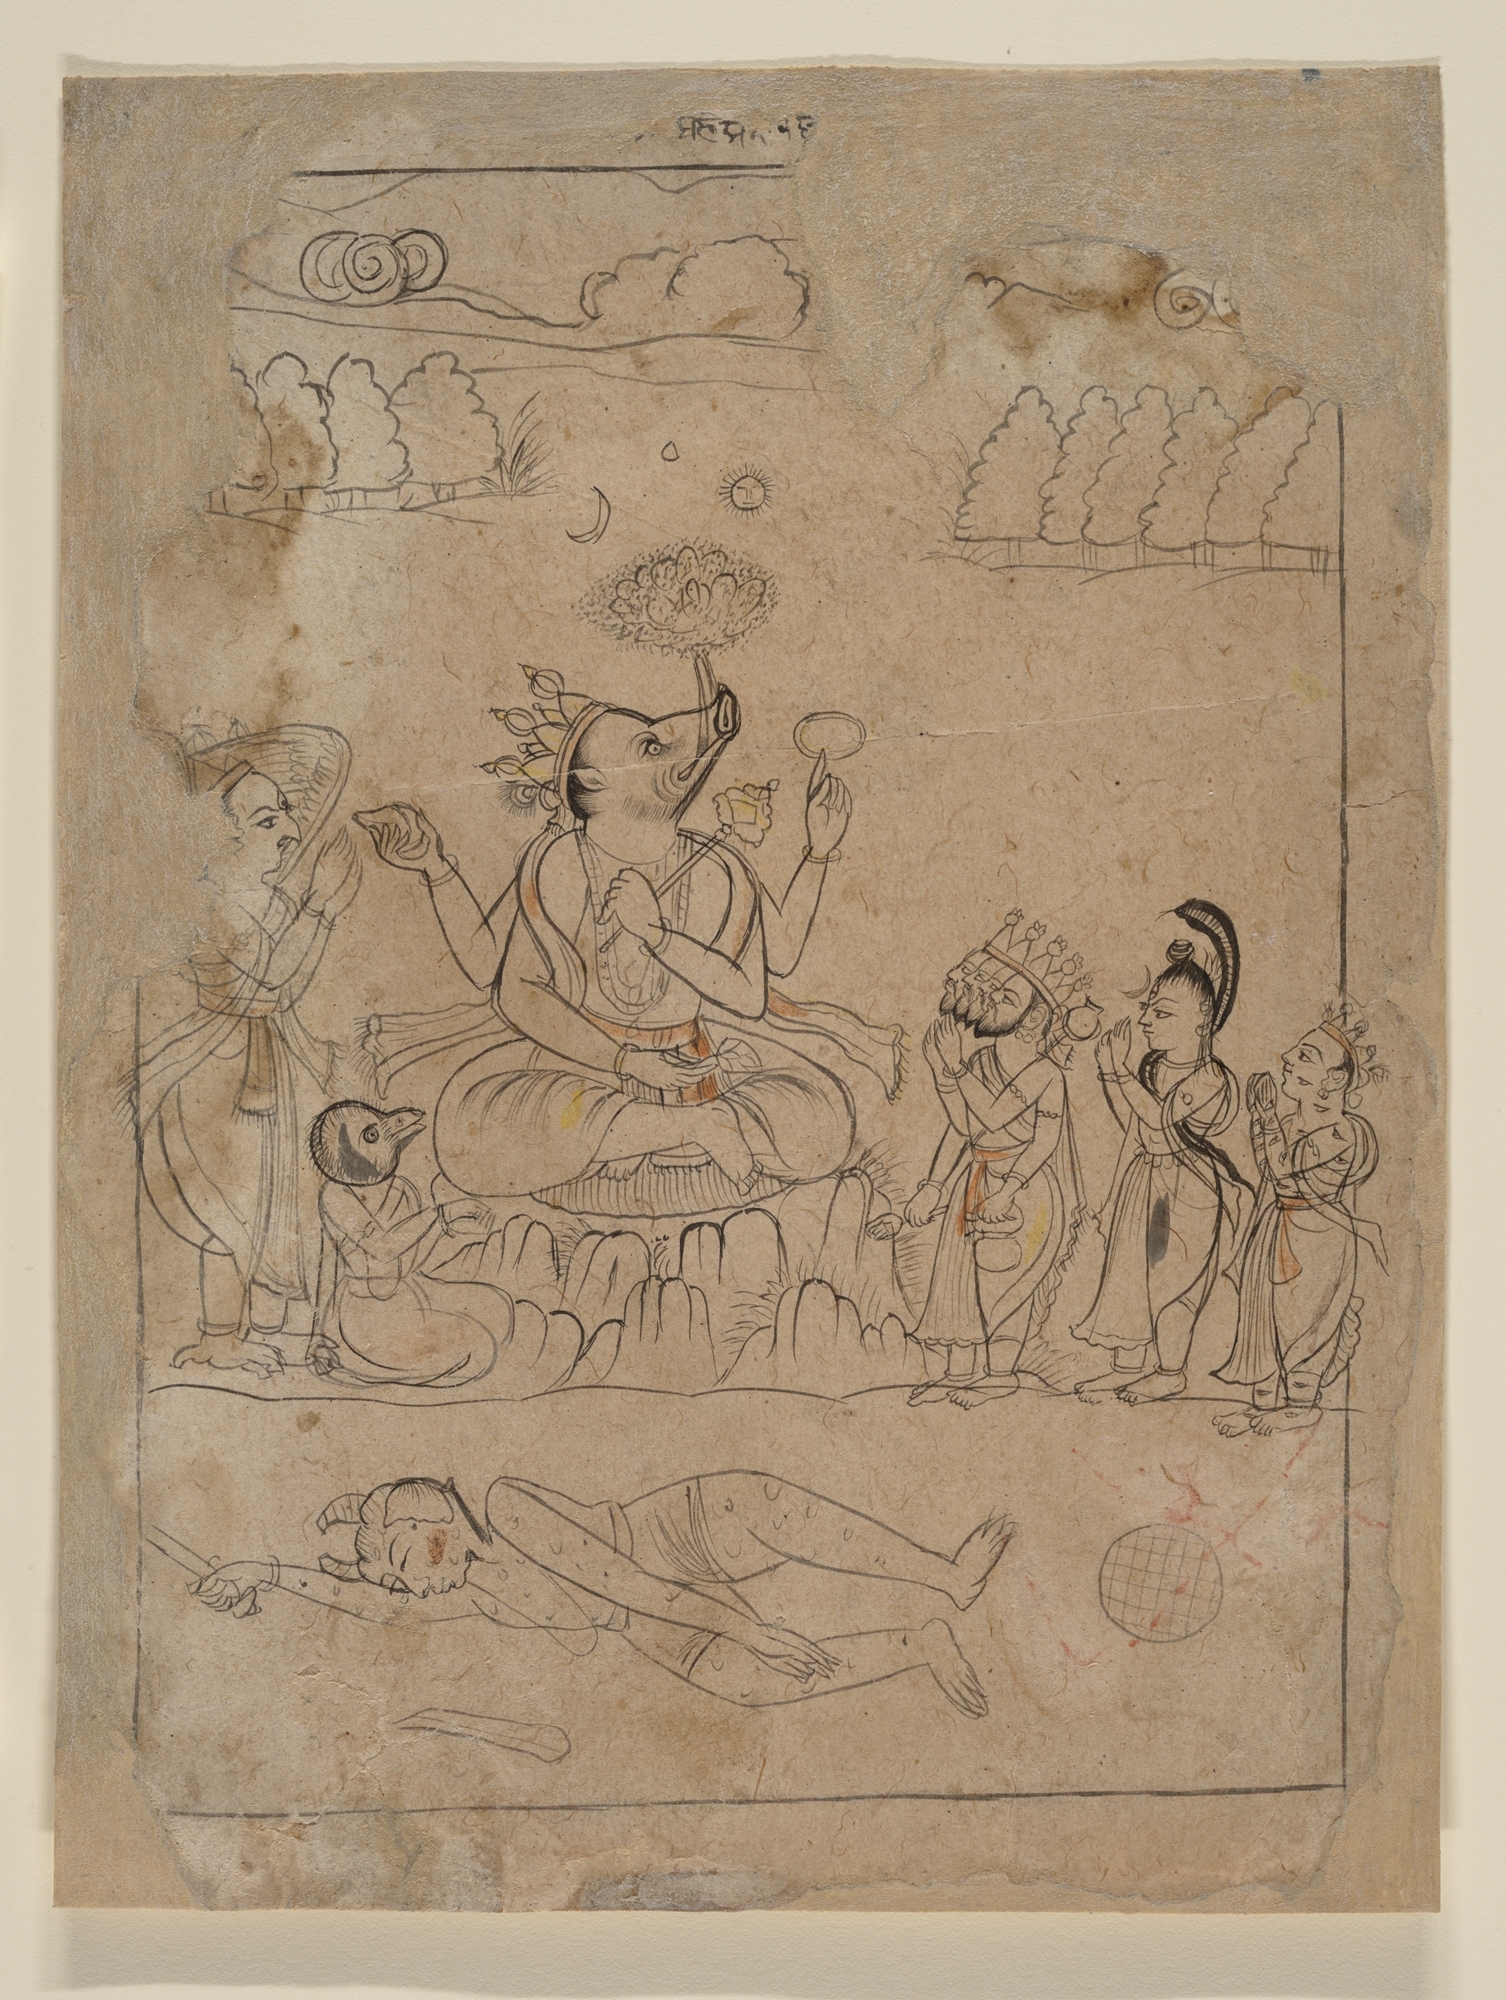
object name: painting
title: Varaha Triumphant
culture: indian, rajasthani, sawar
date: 1767-1800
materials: ink, paper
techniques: wash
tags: demons,krishna,hinduism